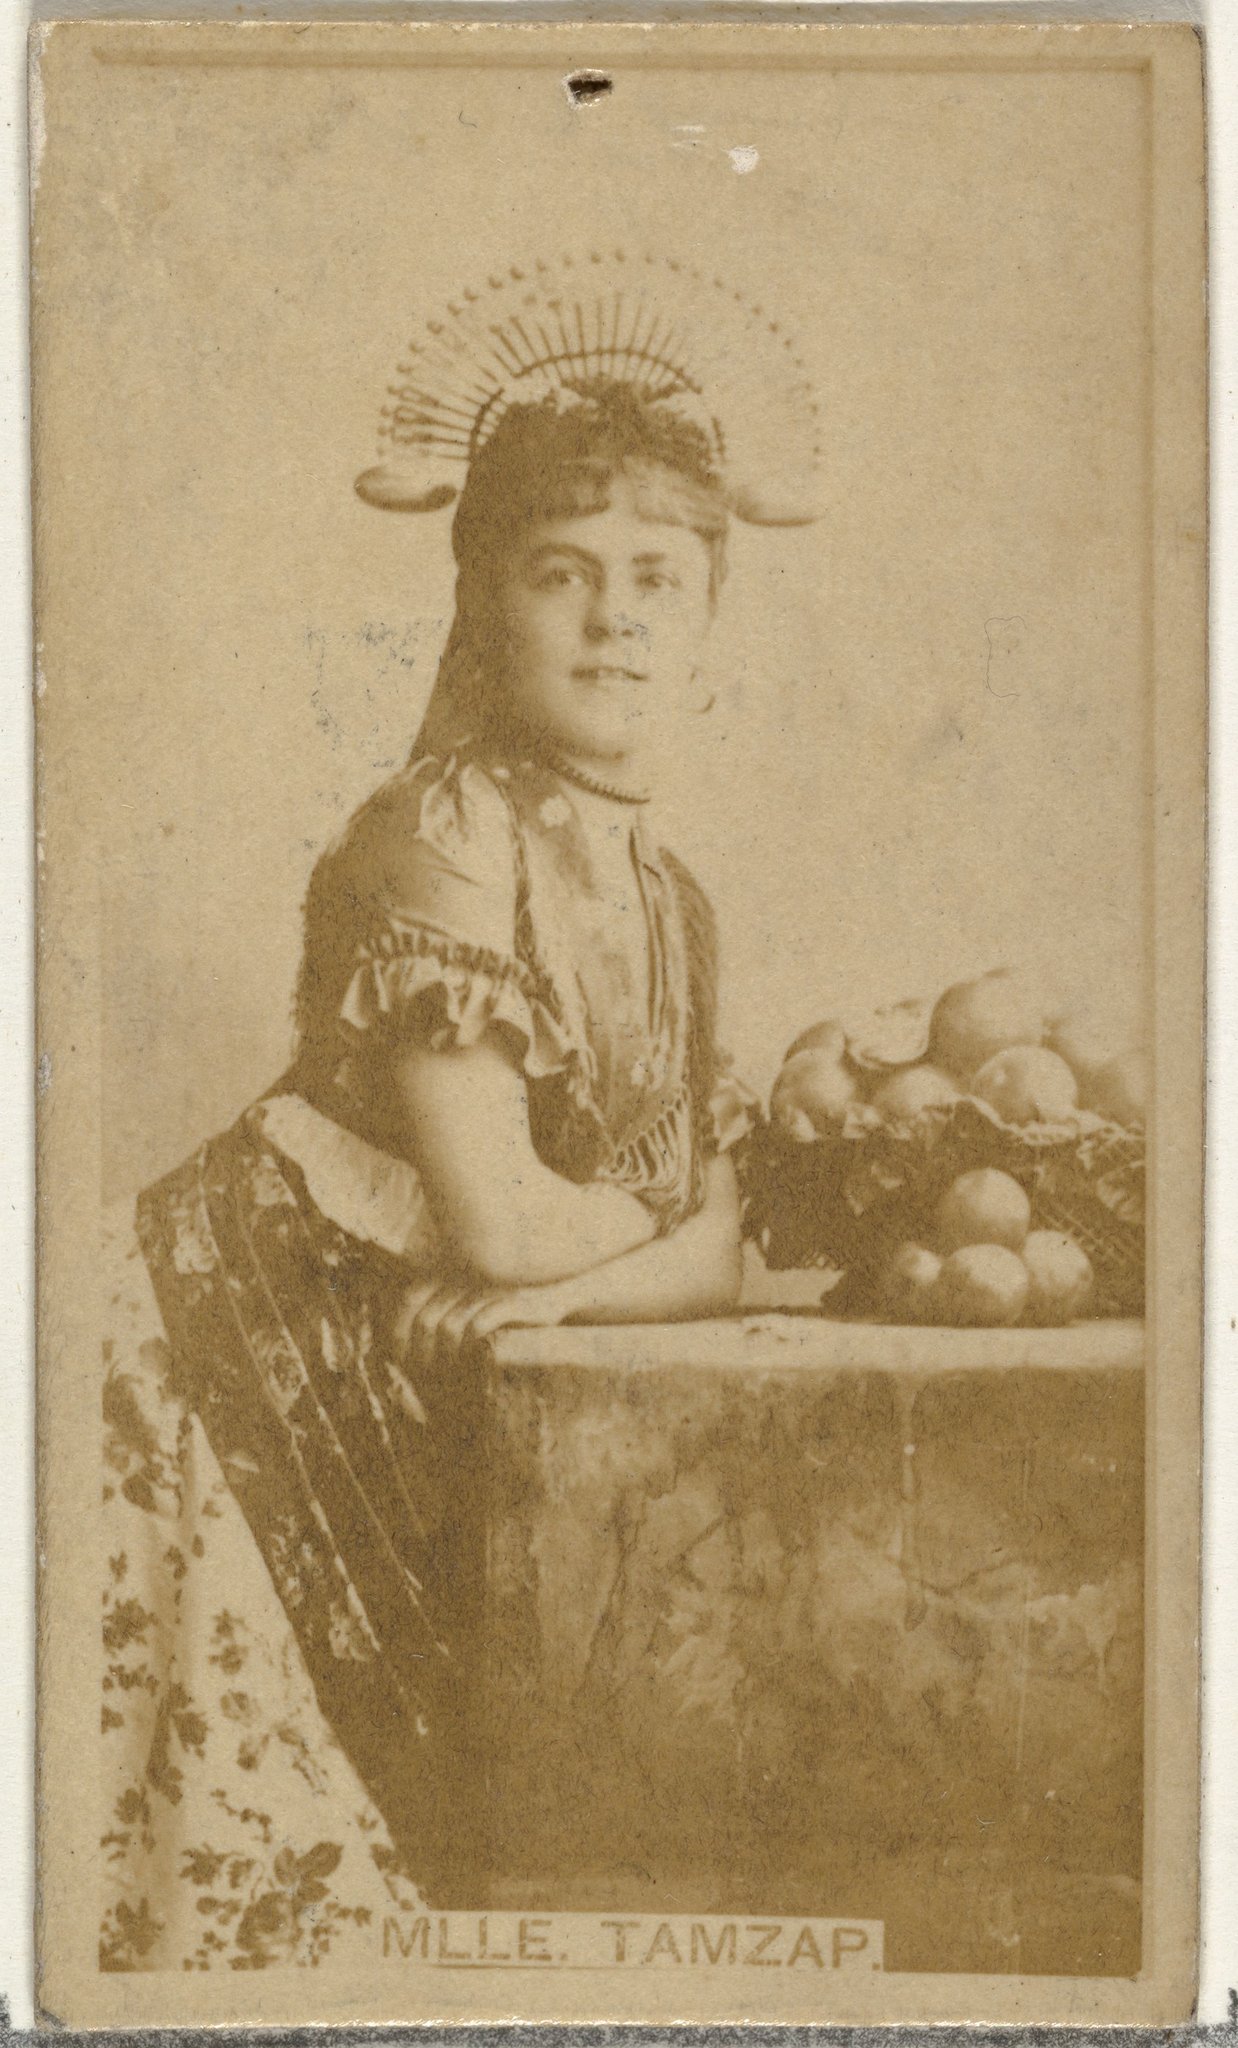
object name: photograph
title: Mlle. Tamzap, from the Actors and Actresses series (N145-8) issued by Duke Sons & Co. to promote Duke Cigarettes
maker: w. duke, sons & co.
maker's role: publisher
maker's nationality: american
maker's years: 1870-1920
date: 1891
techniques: albumen silver print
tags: portraits,women,actresses